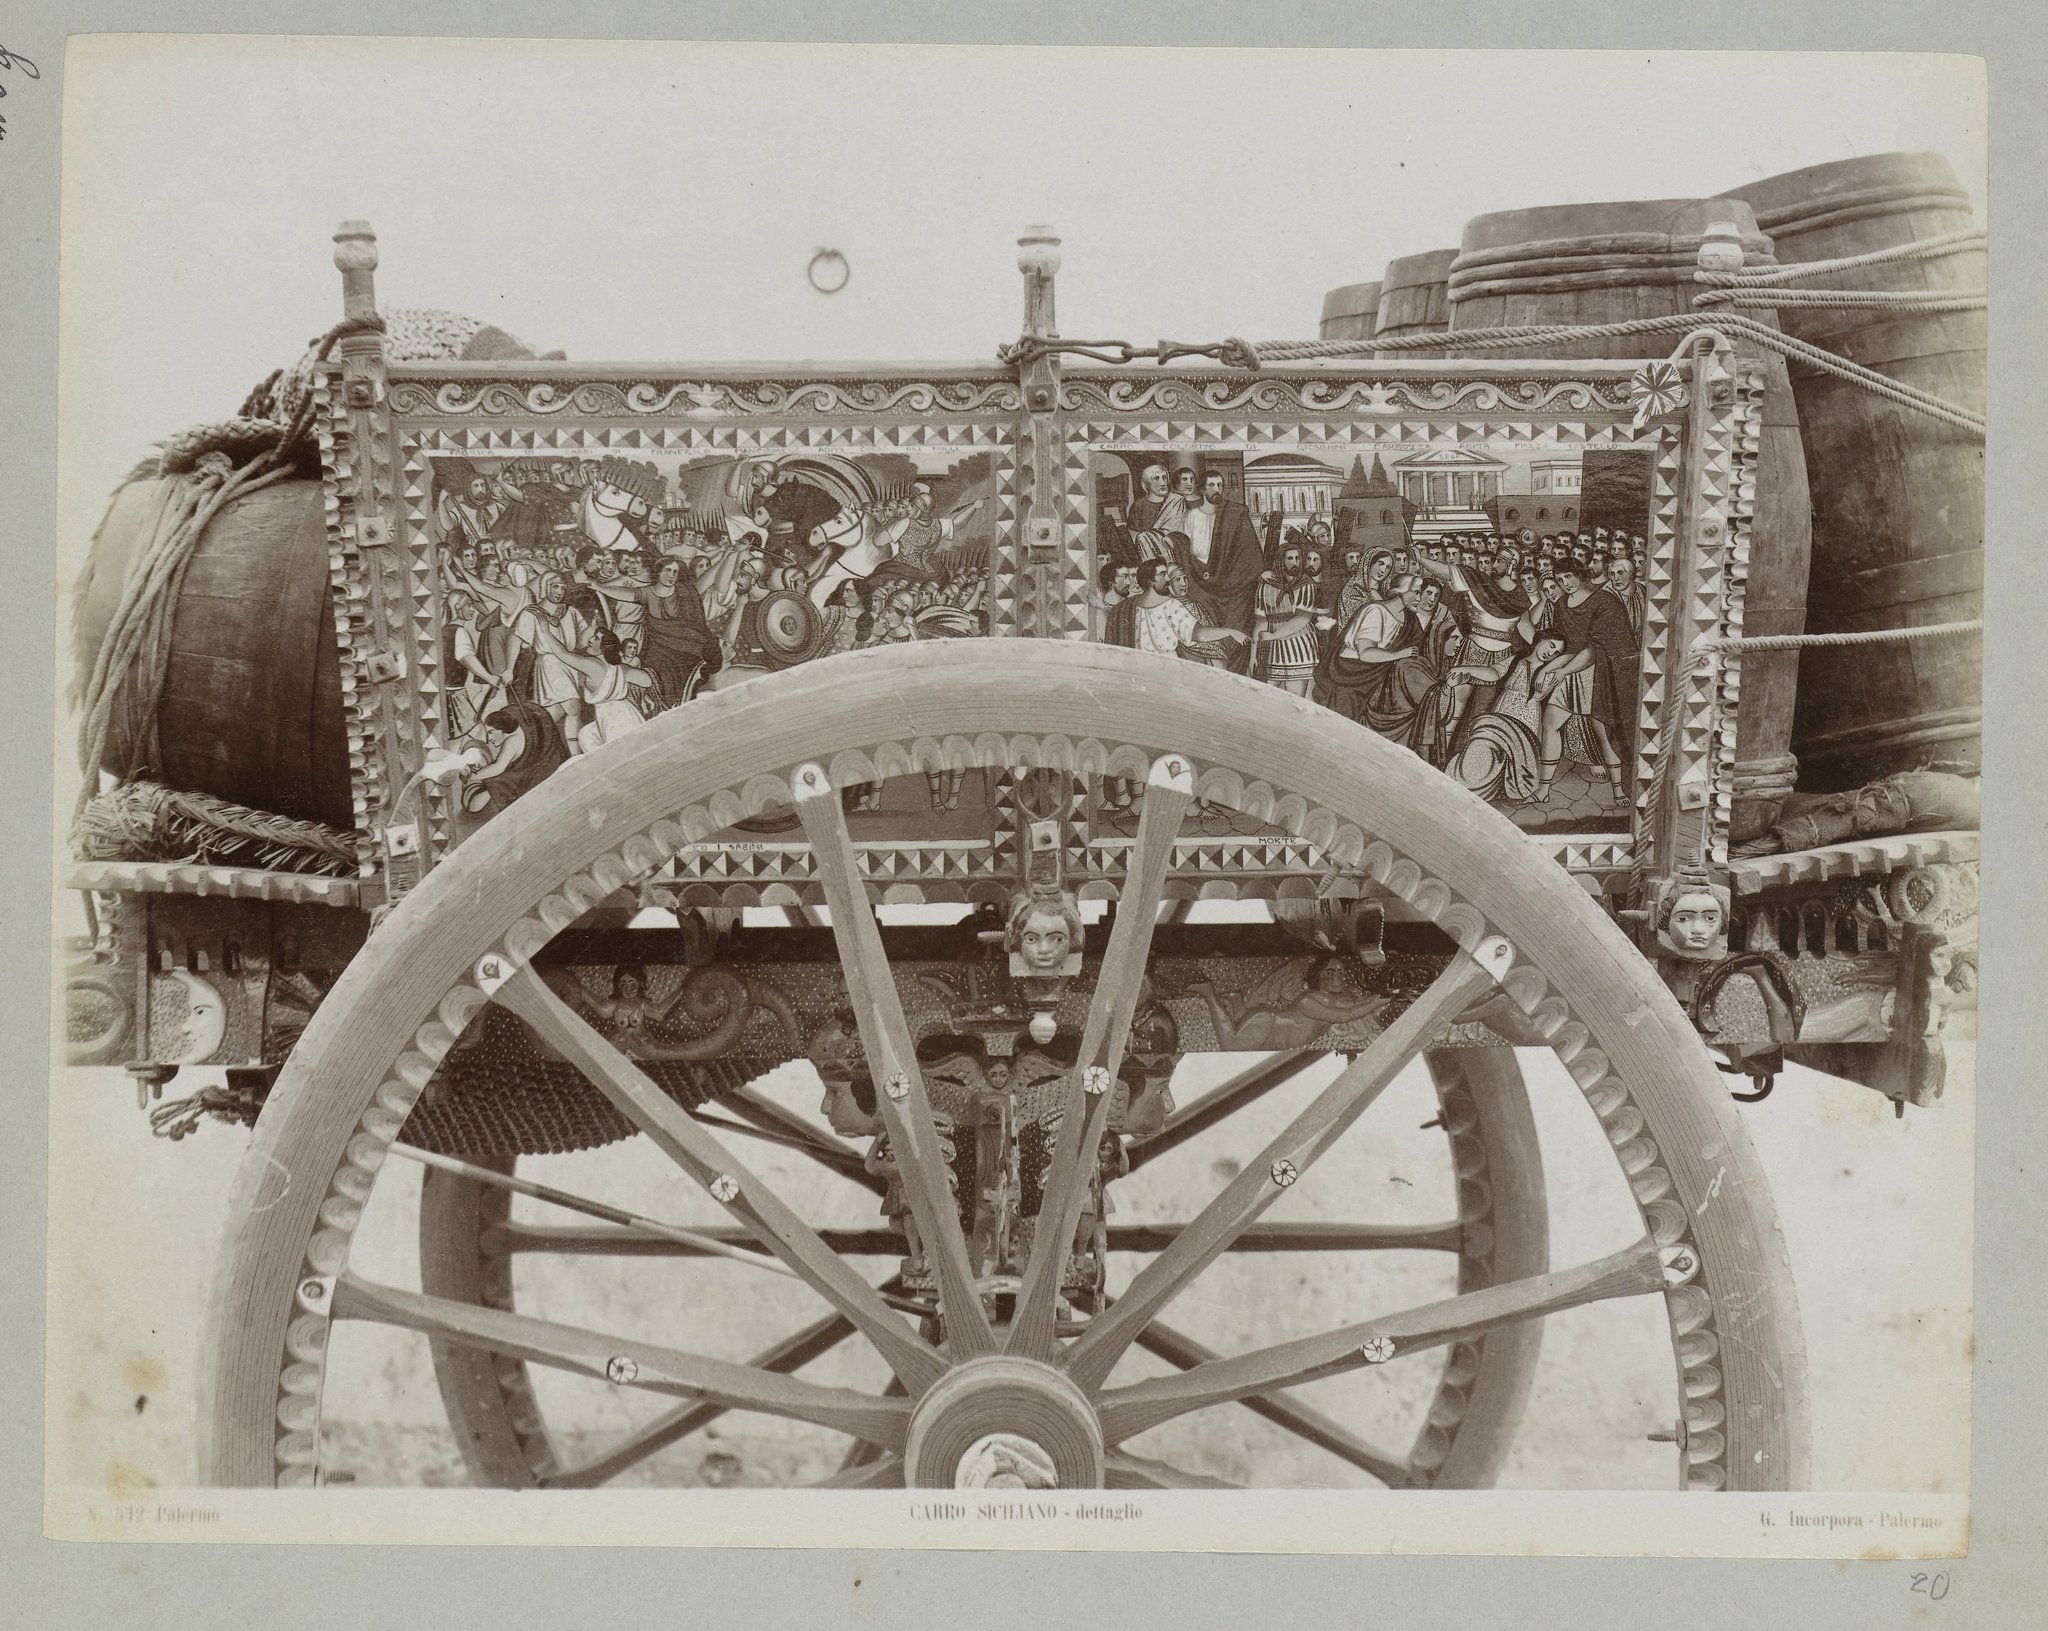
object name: photograph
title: Siciliaanse kar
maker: giuseppe incorpora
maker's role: fotograaf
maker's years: 1834-1914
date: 1893-1903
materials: cardboard, photographic support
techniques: albumen print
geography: palermo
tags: palermo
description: Een bewerkte en beschilderde Siciliaanse ezelkar